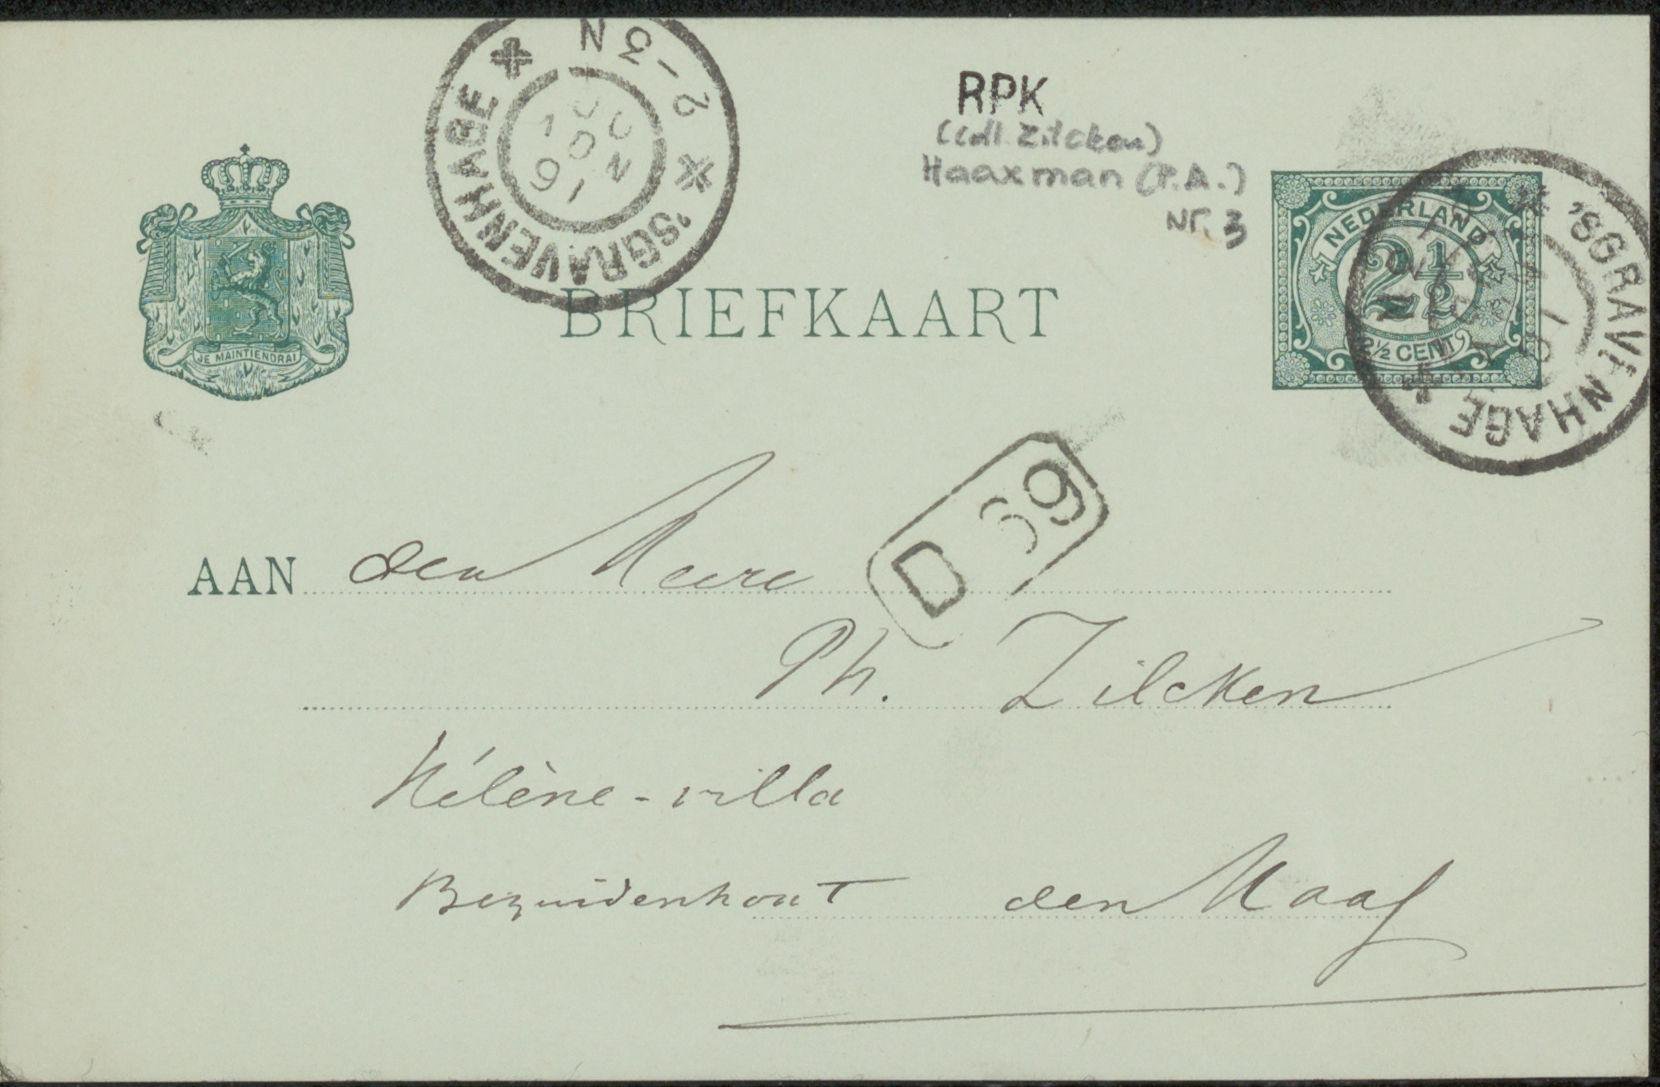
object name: postcard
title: Briefkaart aan Philip Zilcken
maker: pieter anne haaxman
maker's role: journalist, kunstcriticus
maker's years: 1847-1935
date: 1900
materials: cardboard, ink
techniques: pen, writing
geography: the hague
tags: painter, draughtsman, philip zilcken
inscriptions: collector's mark: ‘RPK’